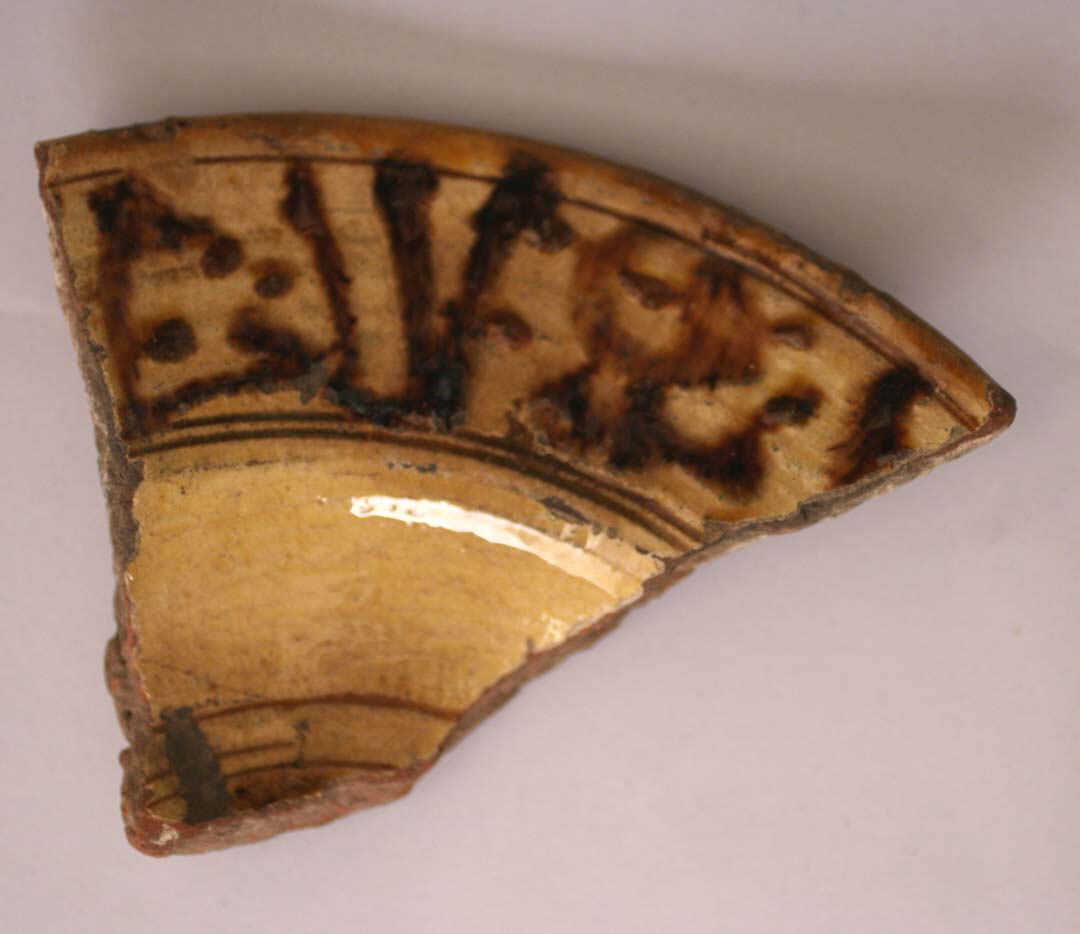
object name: fragment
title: Ceramic Fragment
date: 1301-1500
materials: earthenware, glaze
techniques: coloring, incising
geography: egypt